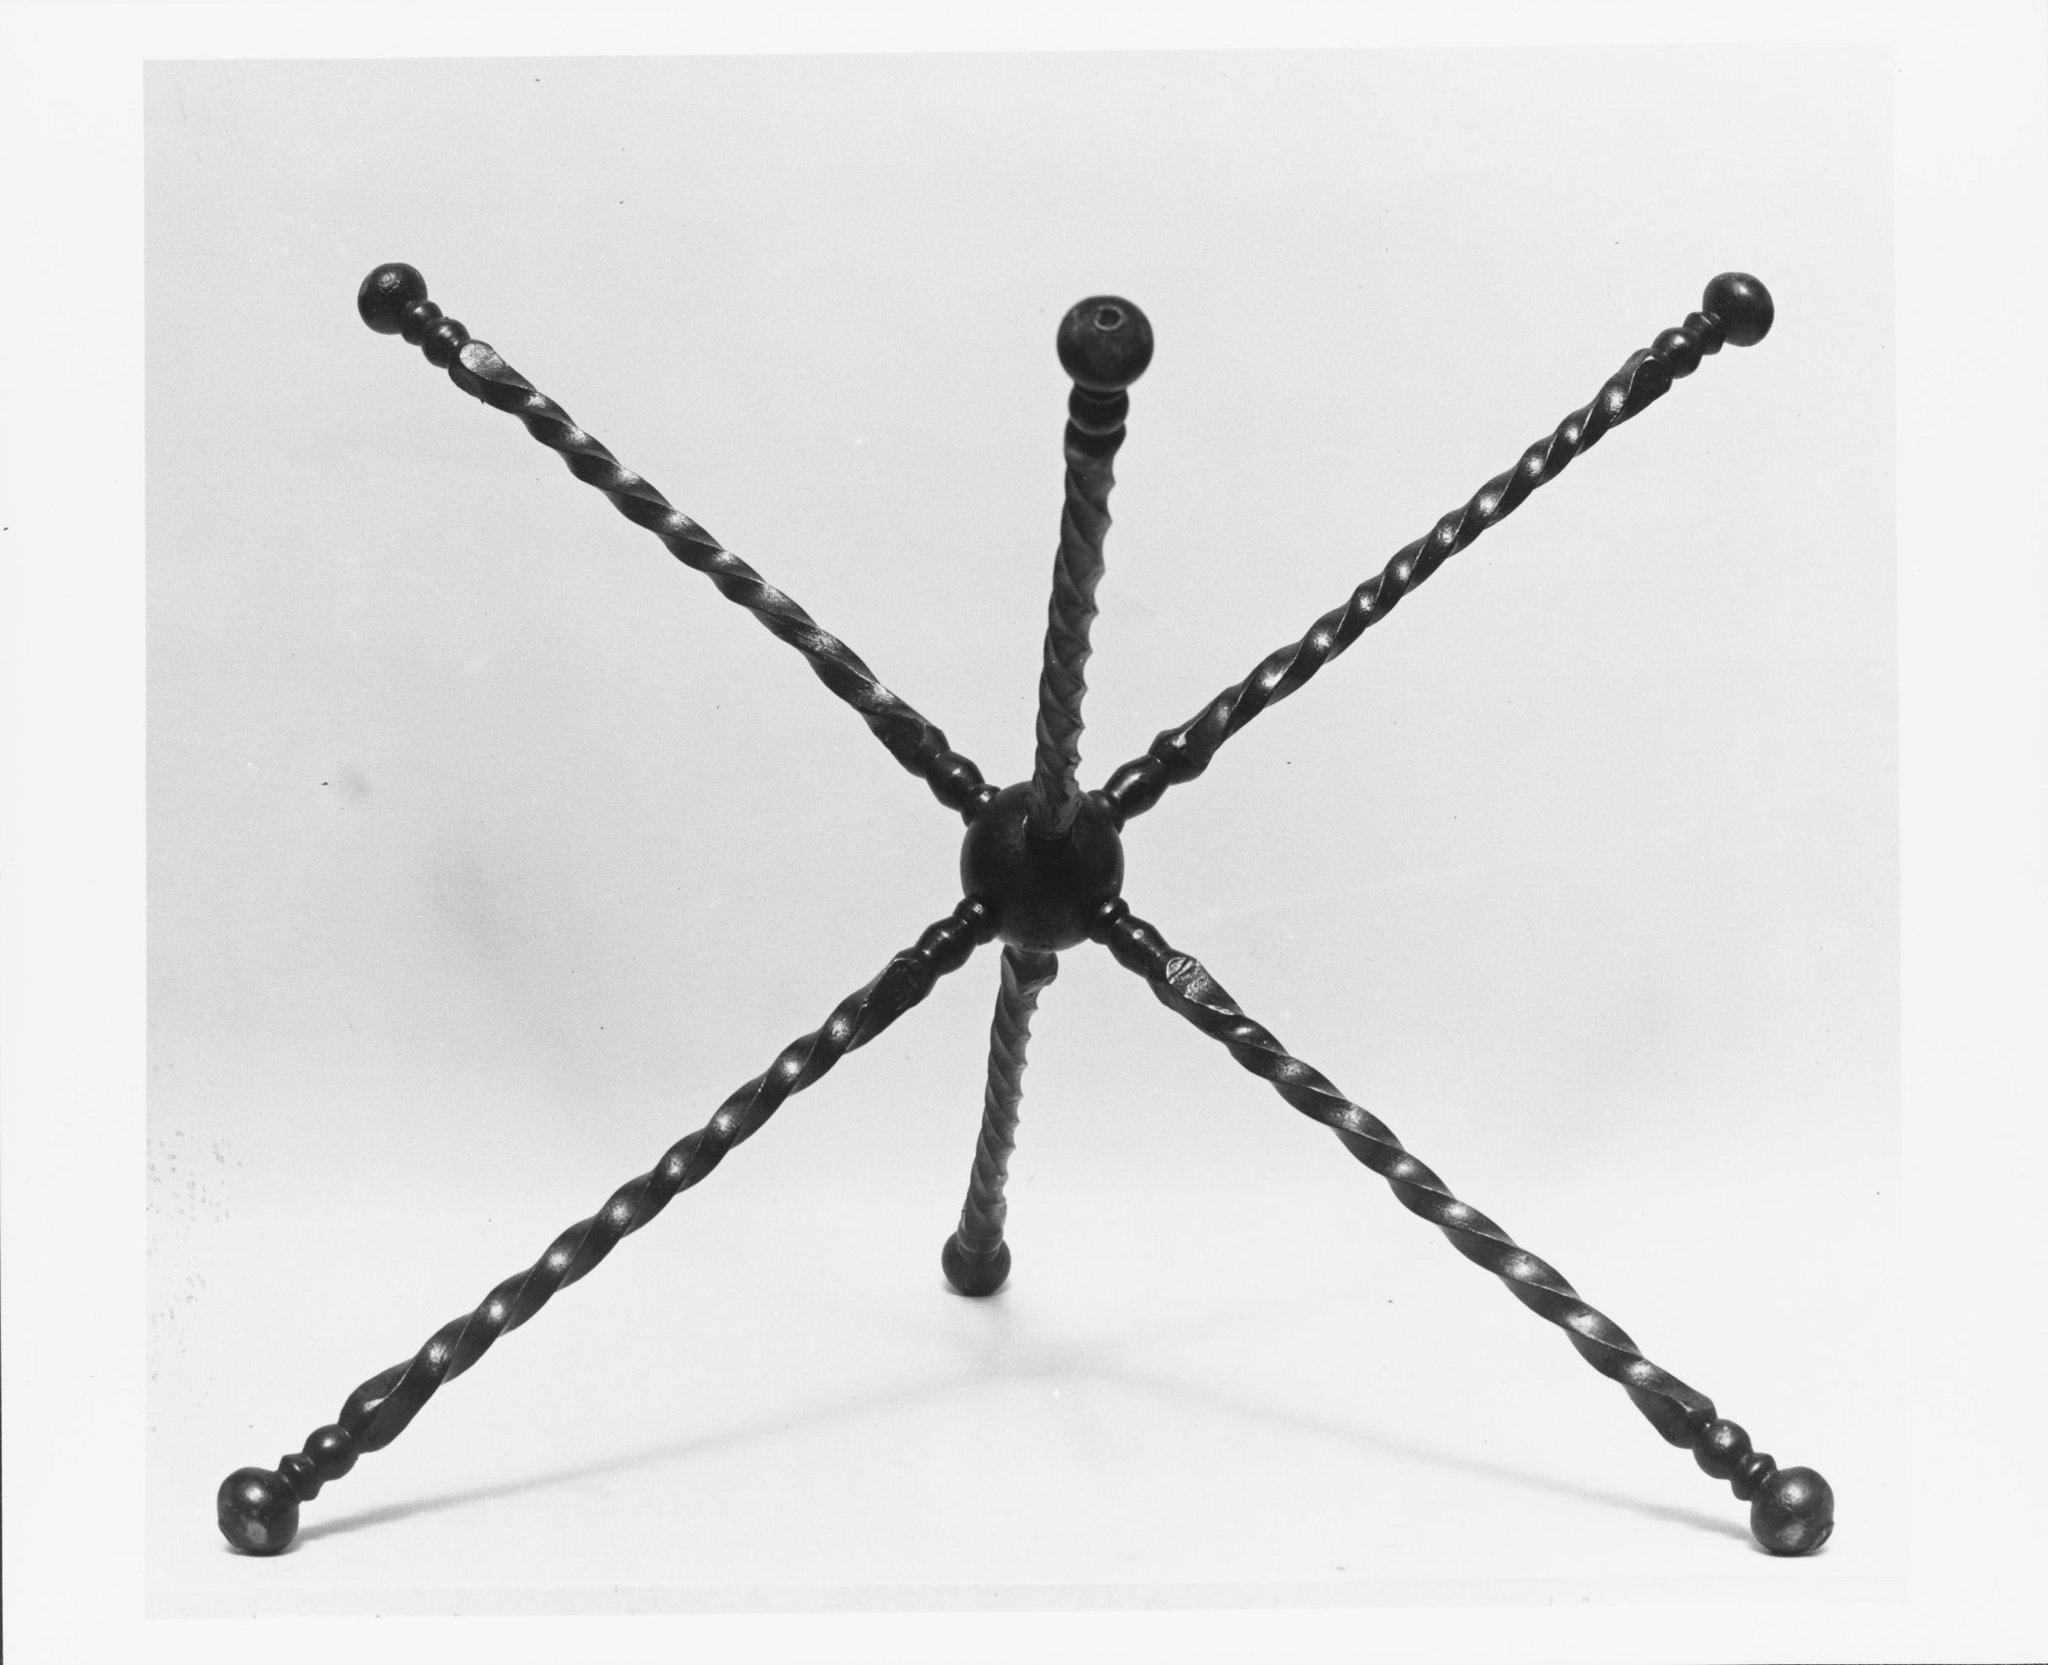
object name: trivet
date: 1770-1800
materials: iron